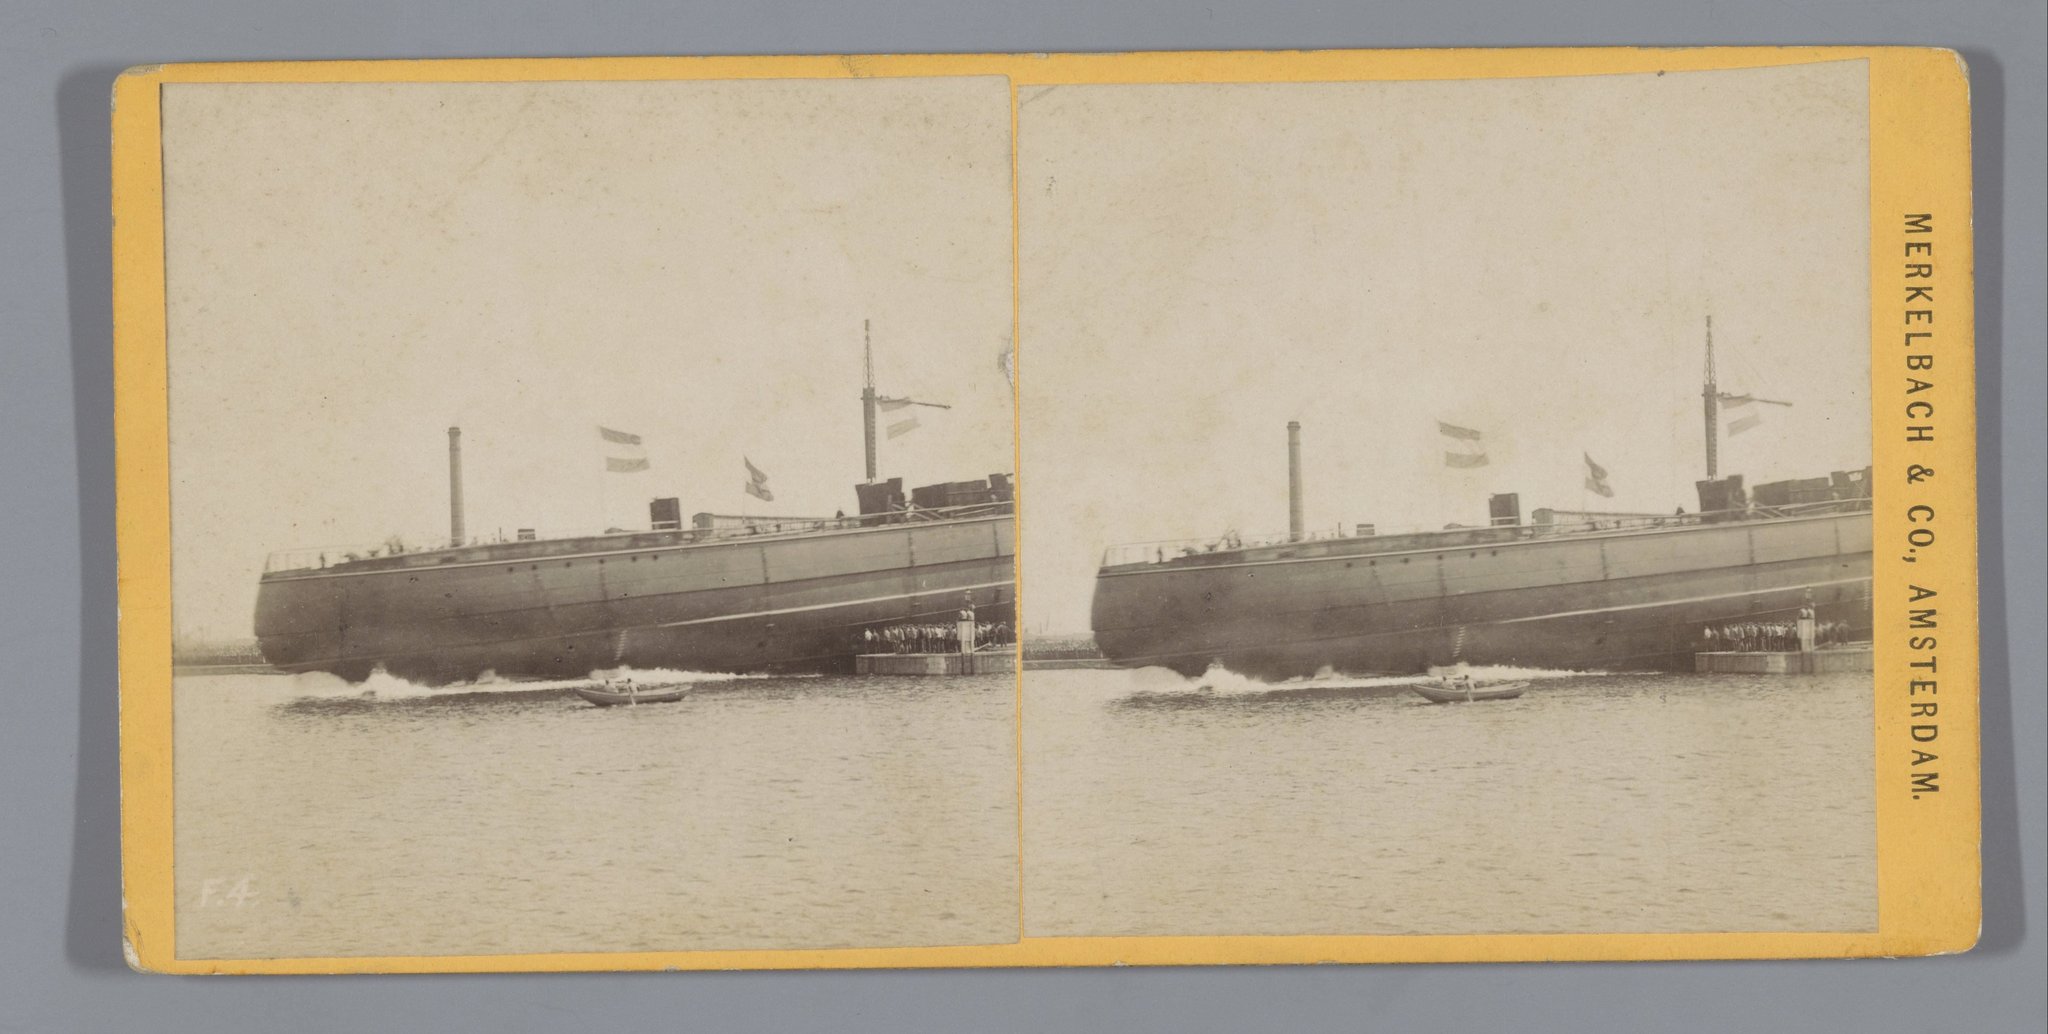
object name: stereograph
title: Het afloopen van een schip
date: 1902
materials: cardboard, paper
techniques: albumen print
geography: amsterdam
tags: launching a ship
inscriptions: inscription: ‘F.4.’, number: ‘4.’, inscription: ‘De "Hertog Hendrik" (...) No. 3.’